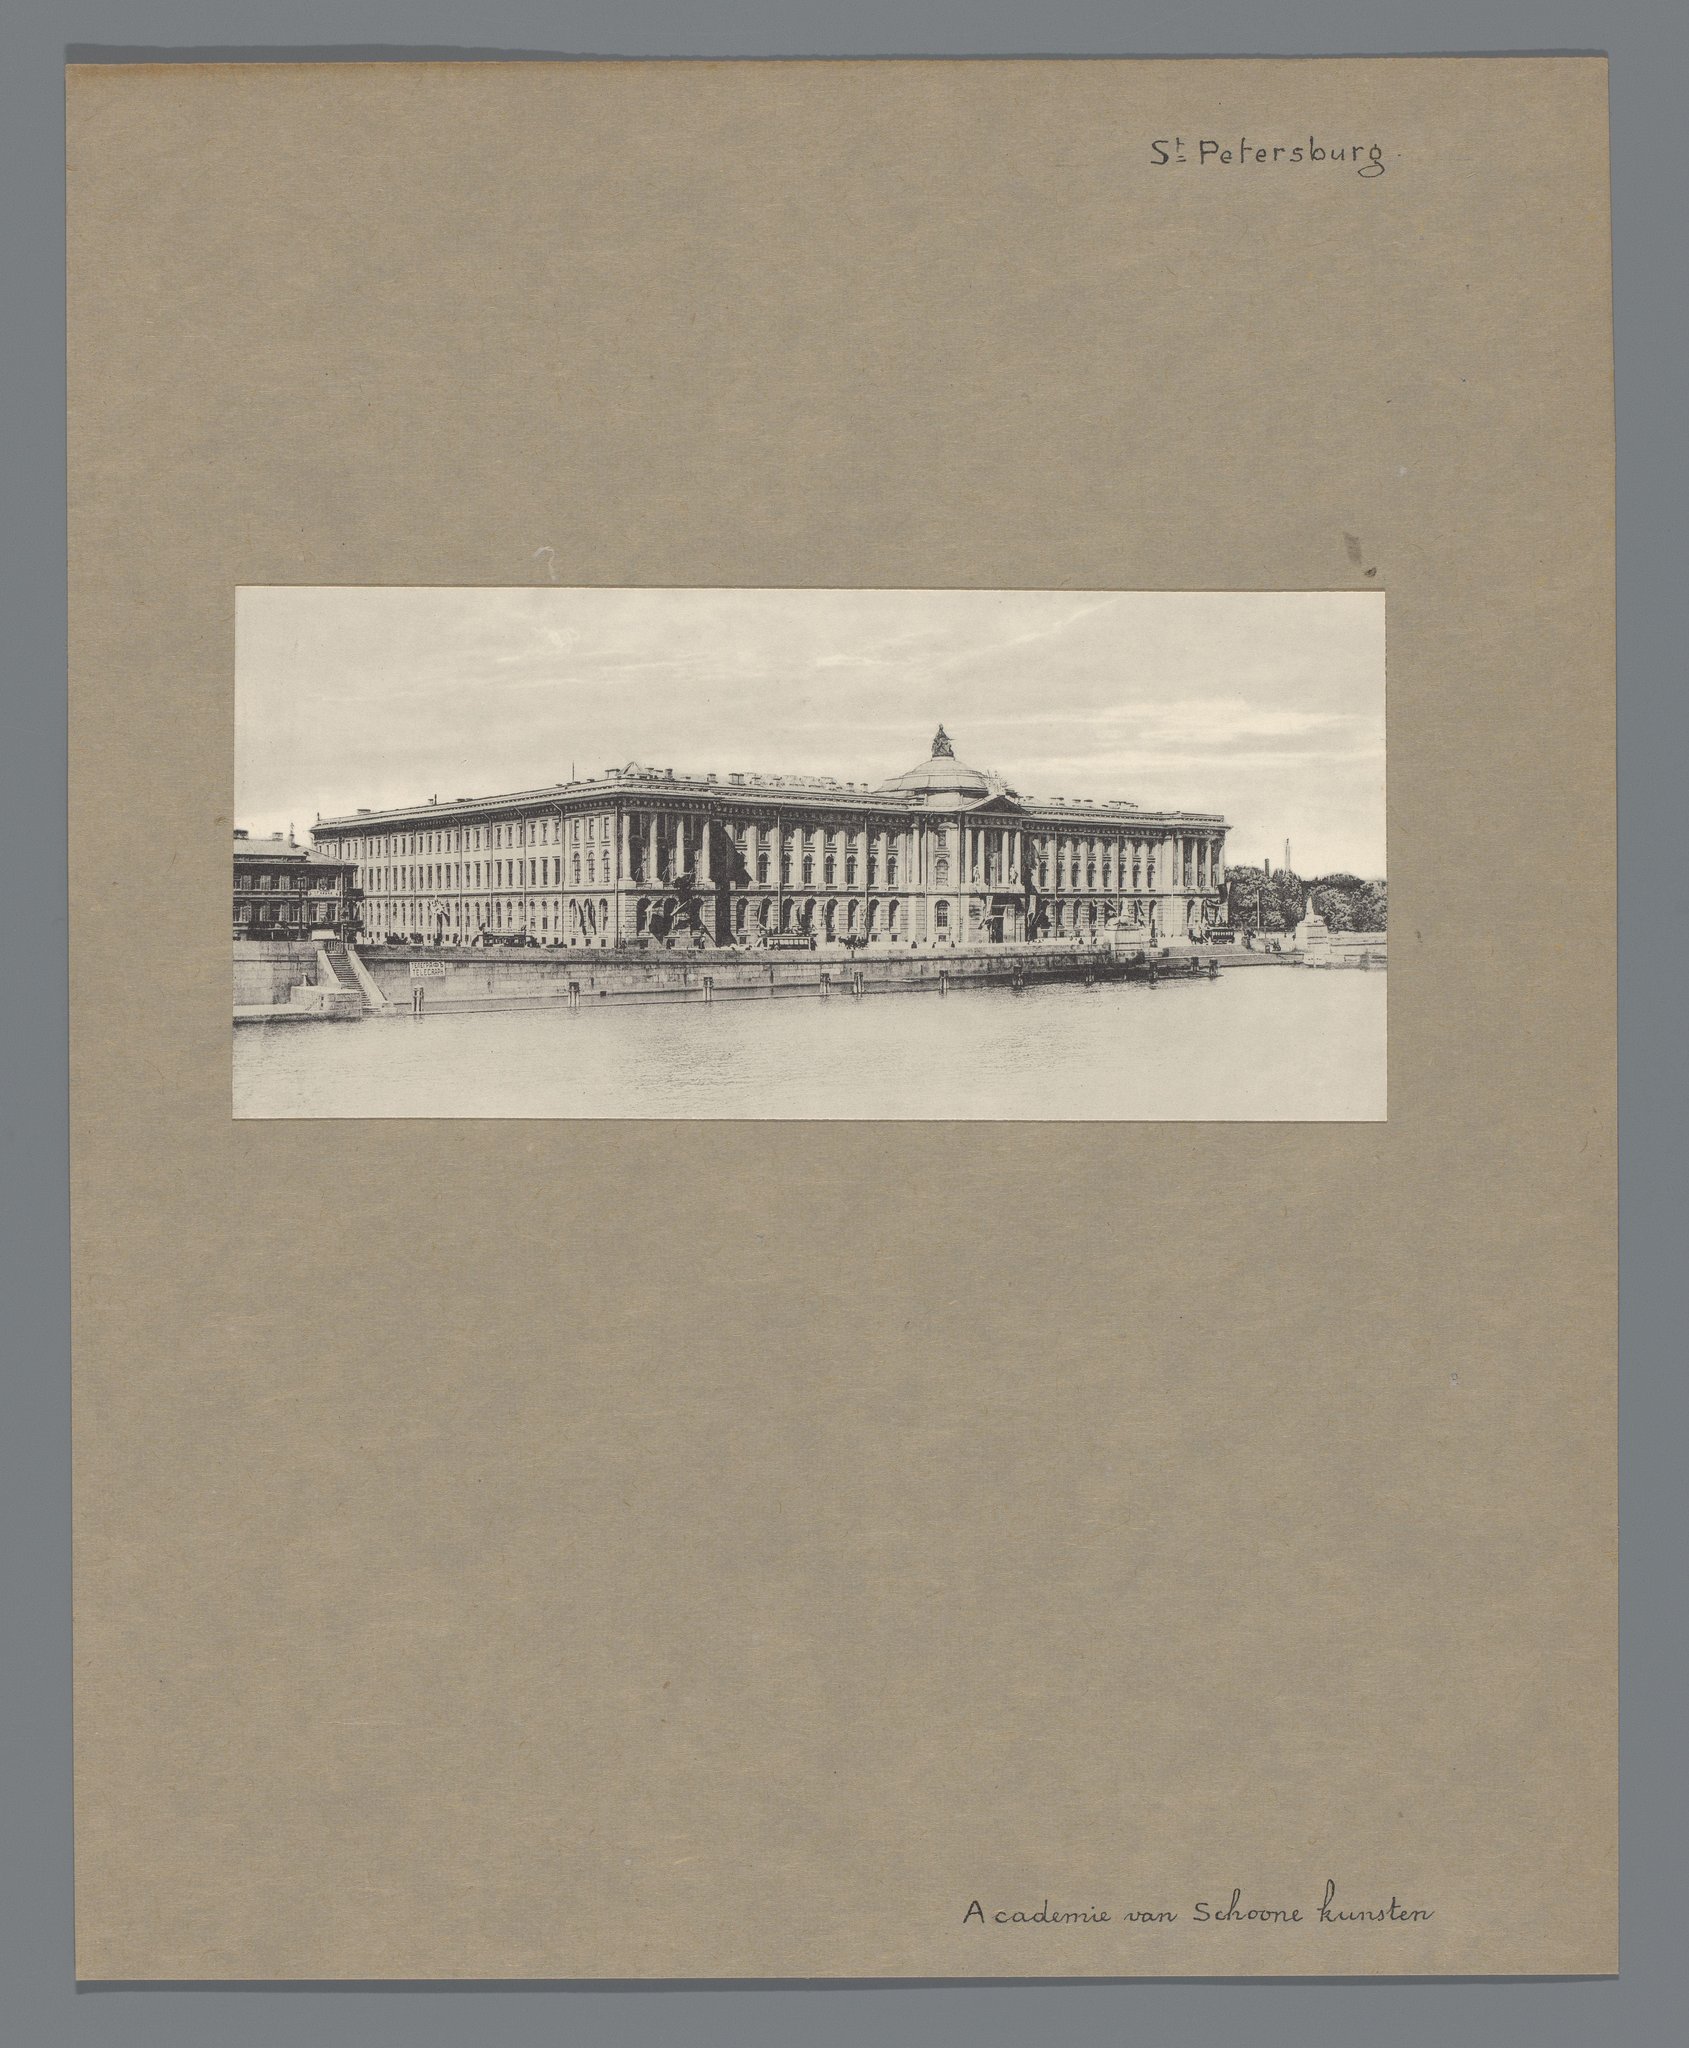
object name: photograph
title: St. Petersburg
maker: Anonymous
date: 1860-1925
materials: photographic support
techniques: photograph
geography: russia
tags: sint-petersburg